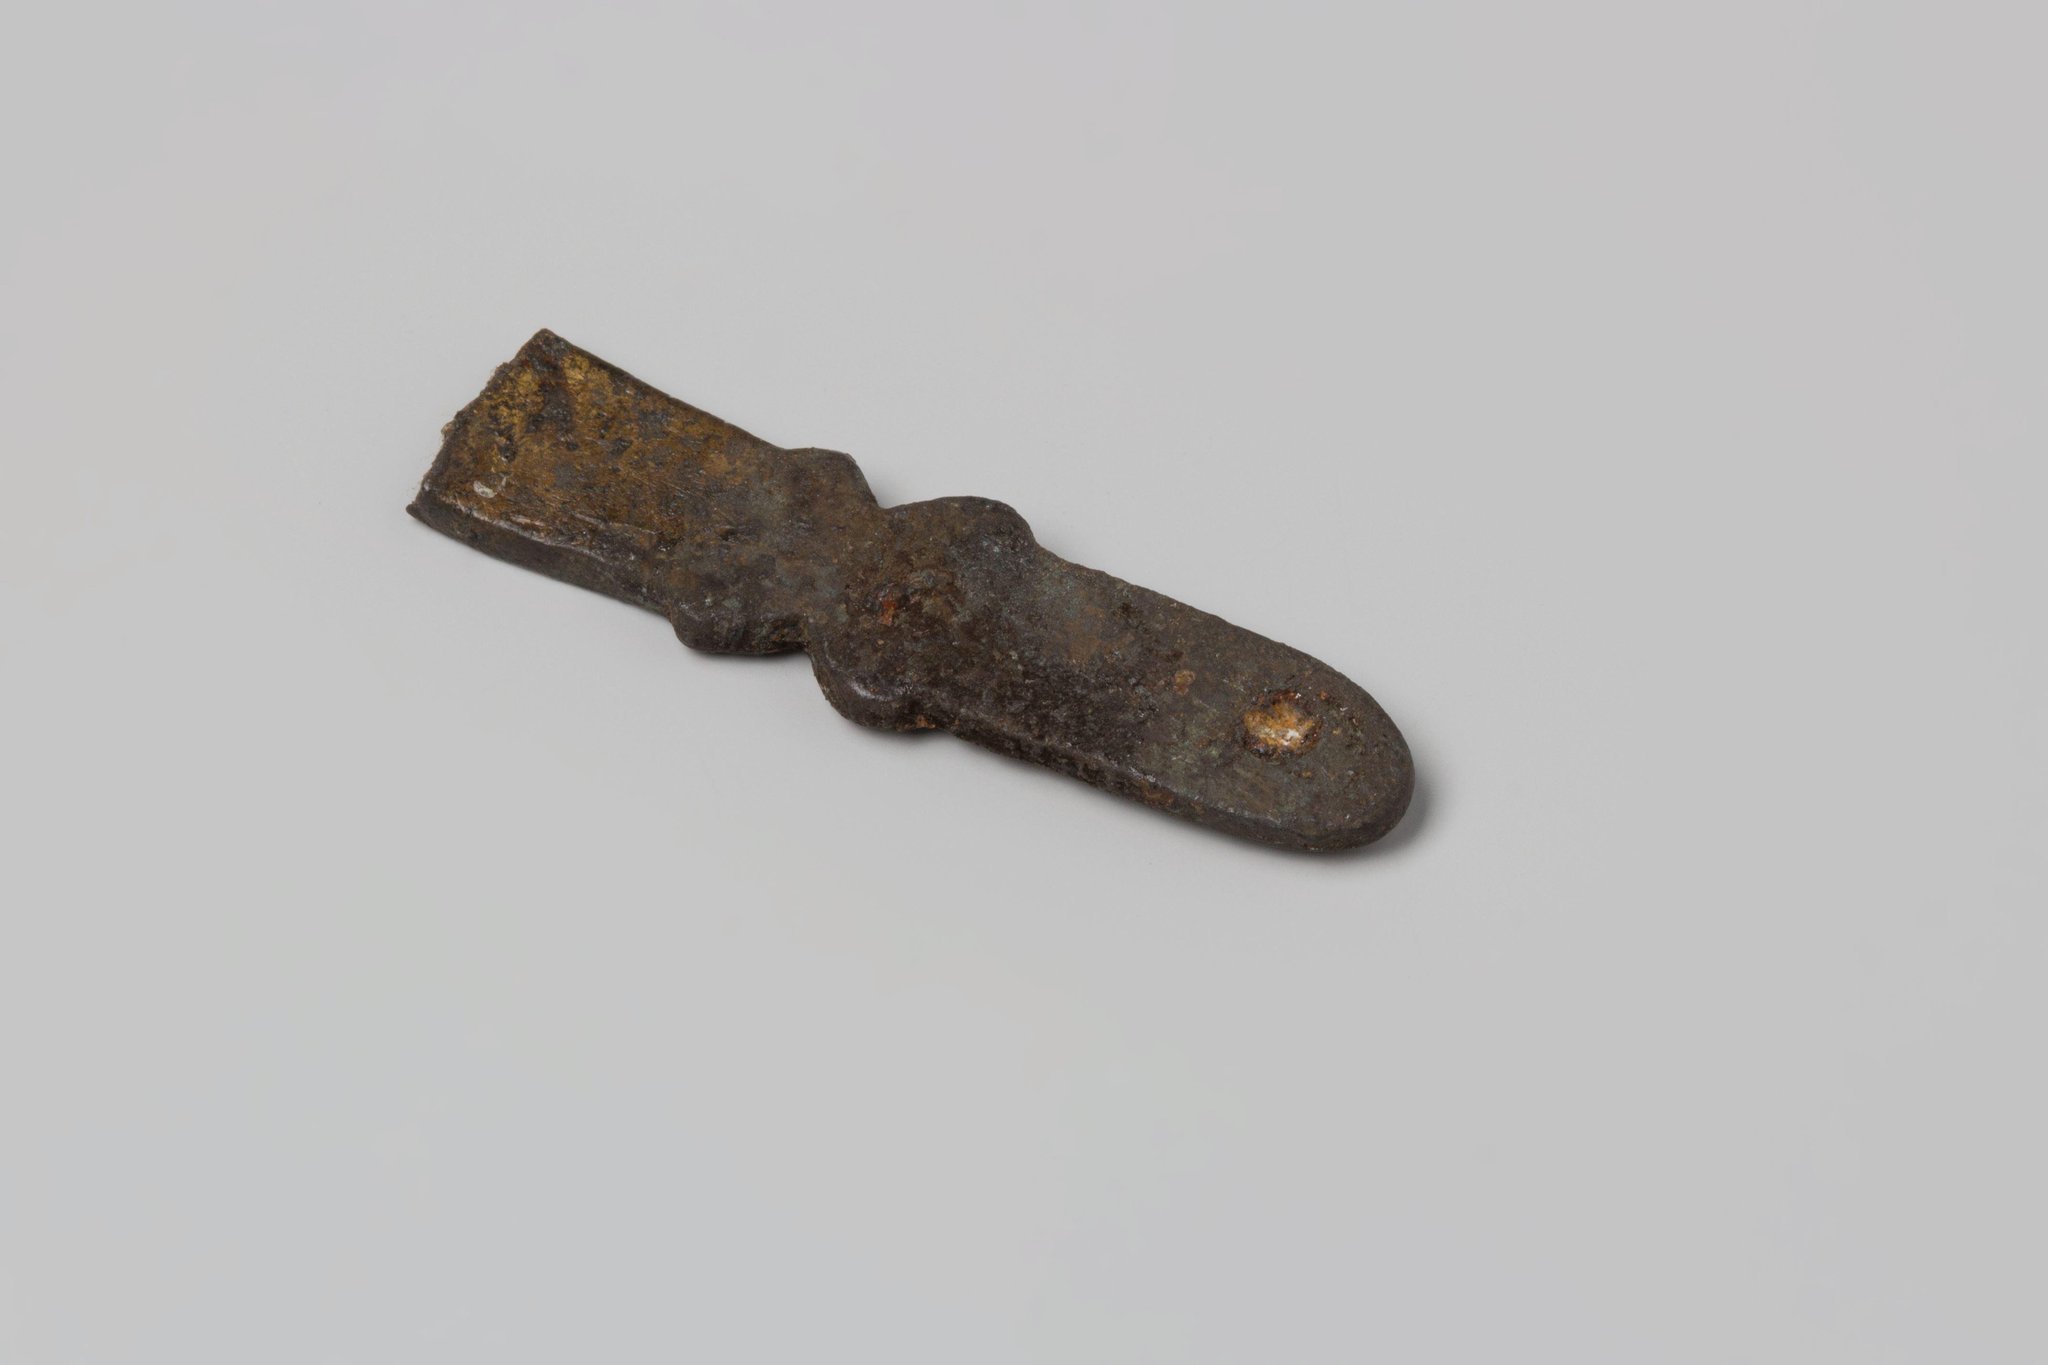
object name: handle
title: Fragment handvat van een lamp uit het wrak van de Oost-Indiëvaarder Hollandia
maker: Anonymous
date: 1700-1743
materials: copper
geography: netherlands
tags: verenigde oostindische compagnie, hollandia (schip), annet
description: Suspension lamp, gimbalring handle; fragm, semicircular end, id. NG 1980-27H900.